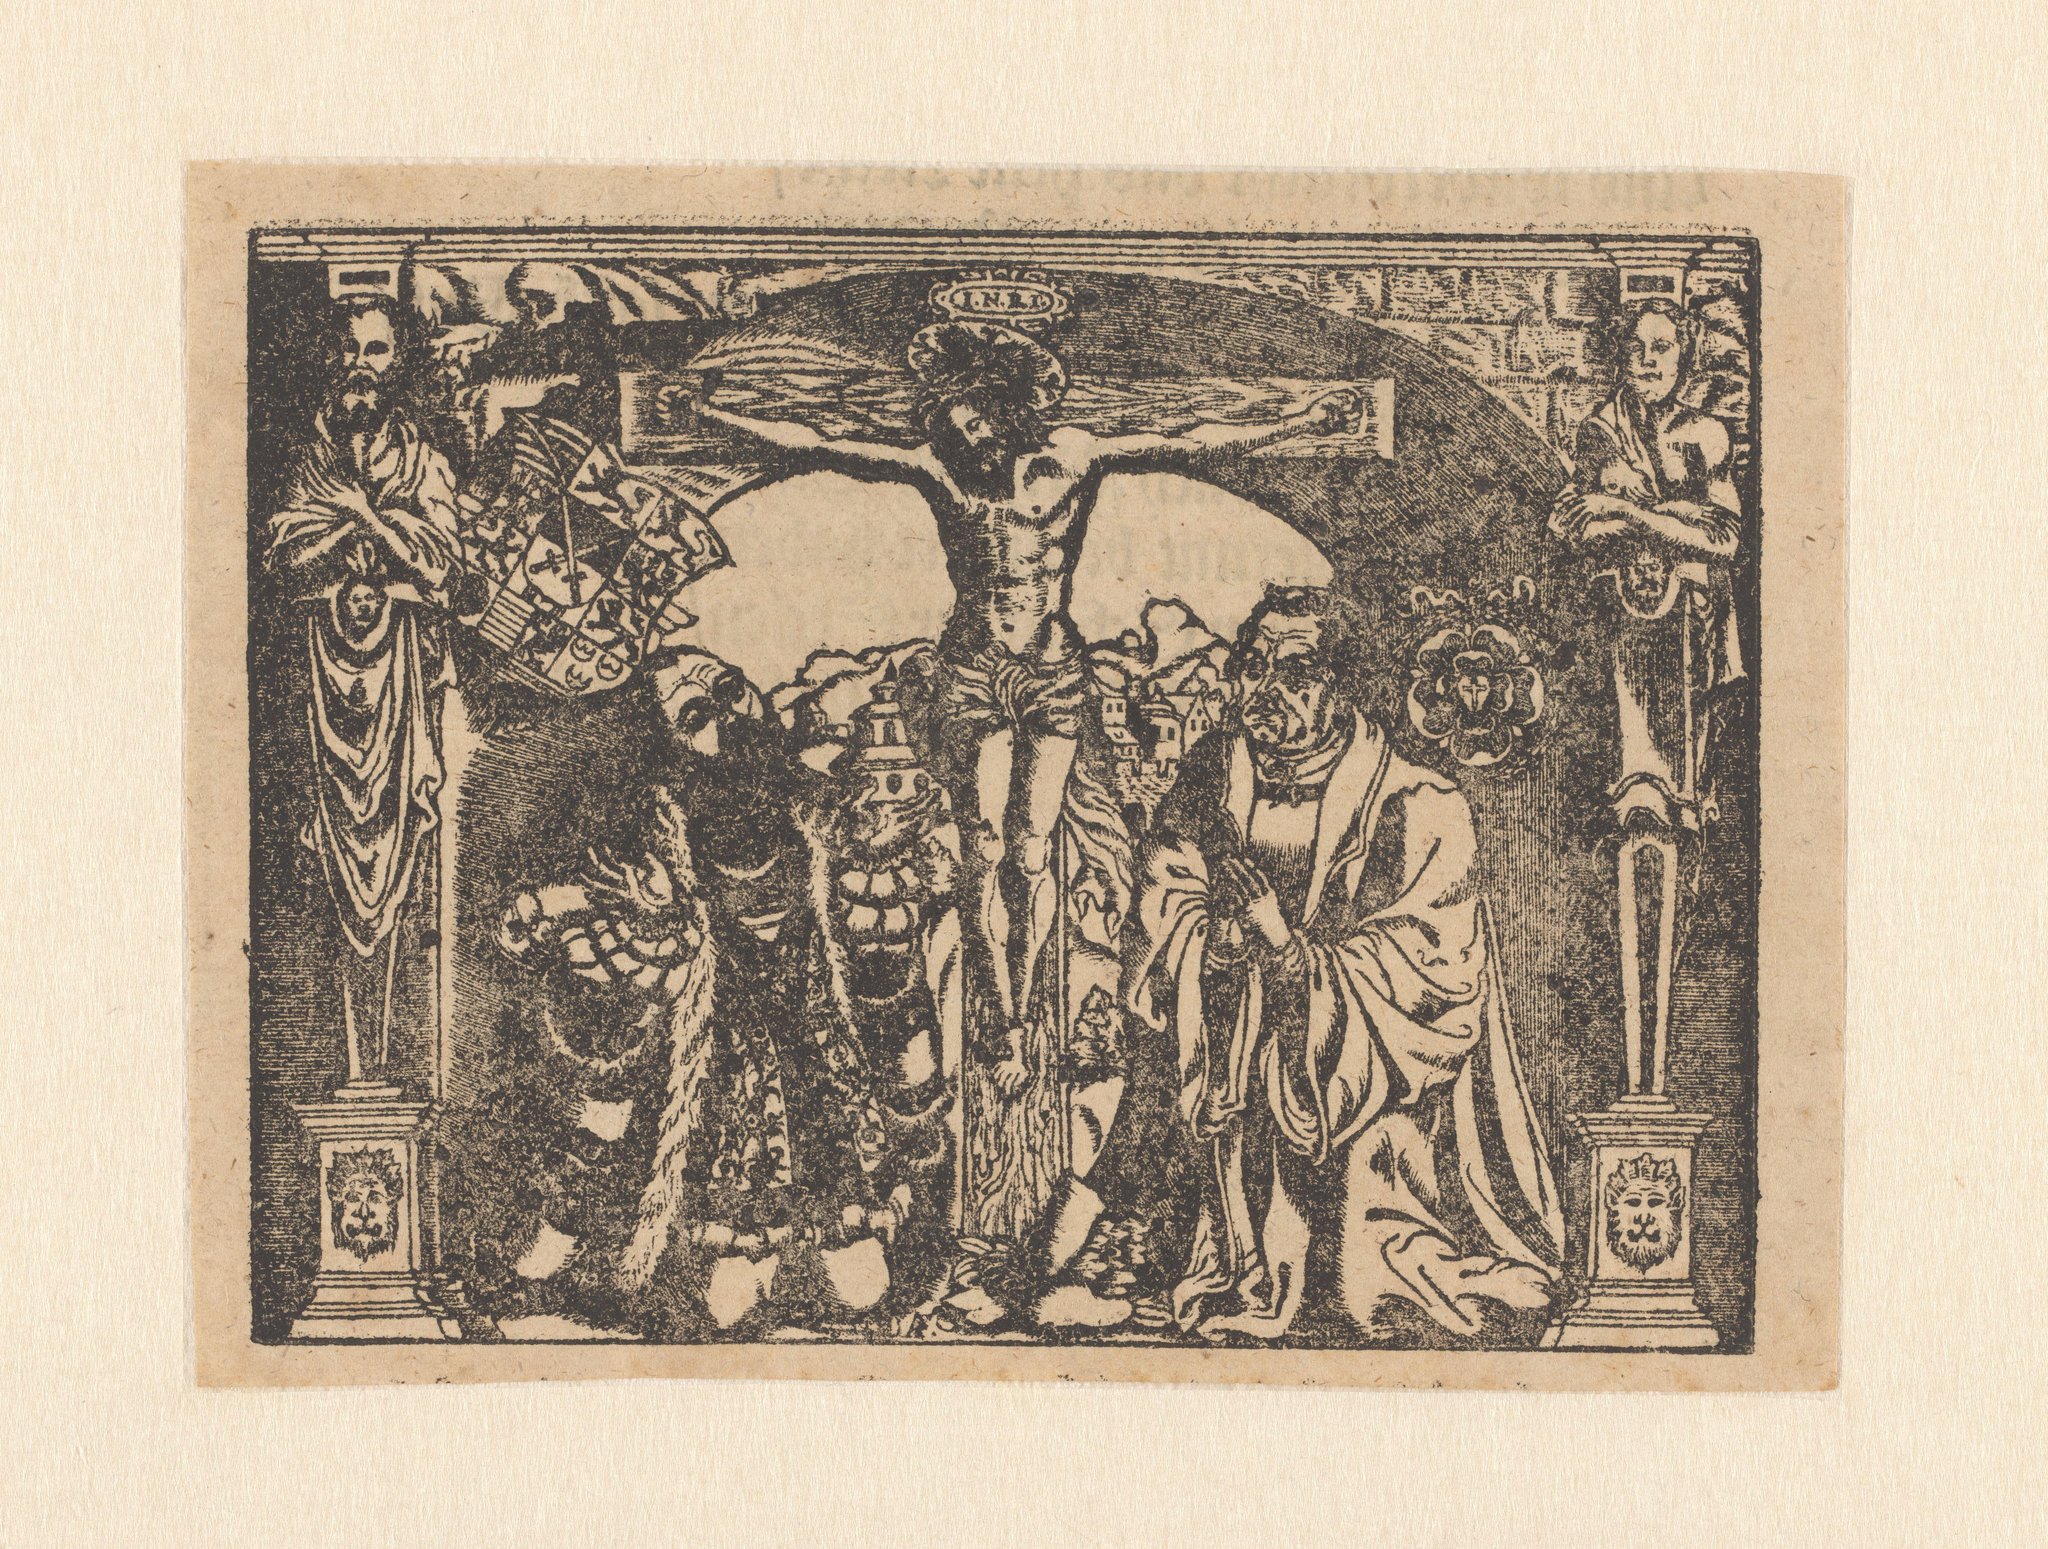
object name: print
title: Keurvorst van Saksen en Martin Luther met Christus aan het kruis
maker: monogrammist gk (prentmaker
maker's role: print maker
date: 1661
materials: paper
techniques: woodcut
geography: europe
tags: priest, martin luther, atlantes ~ architecture, the crucifixion of christ: christ's death on the cross; golgotha (matthew 27:45-58; mark 15:33-45; luke 23:44-52; john 19:25-38)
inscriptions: collector's mark: Lugt 2228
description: Johan de Standvastige, keurvorst van Saksen en Martin Luther geknield ter weerszijden van Christus aan het kruis. In een boog met links en rechts een atlant, op de achtergrond een landschap.